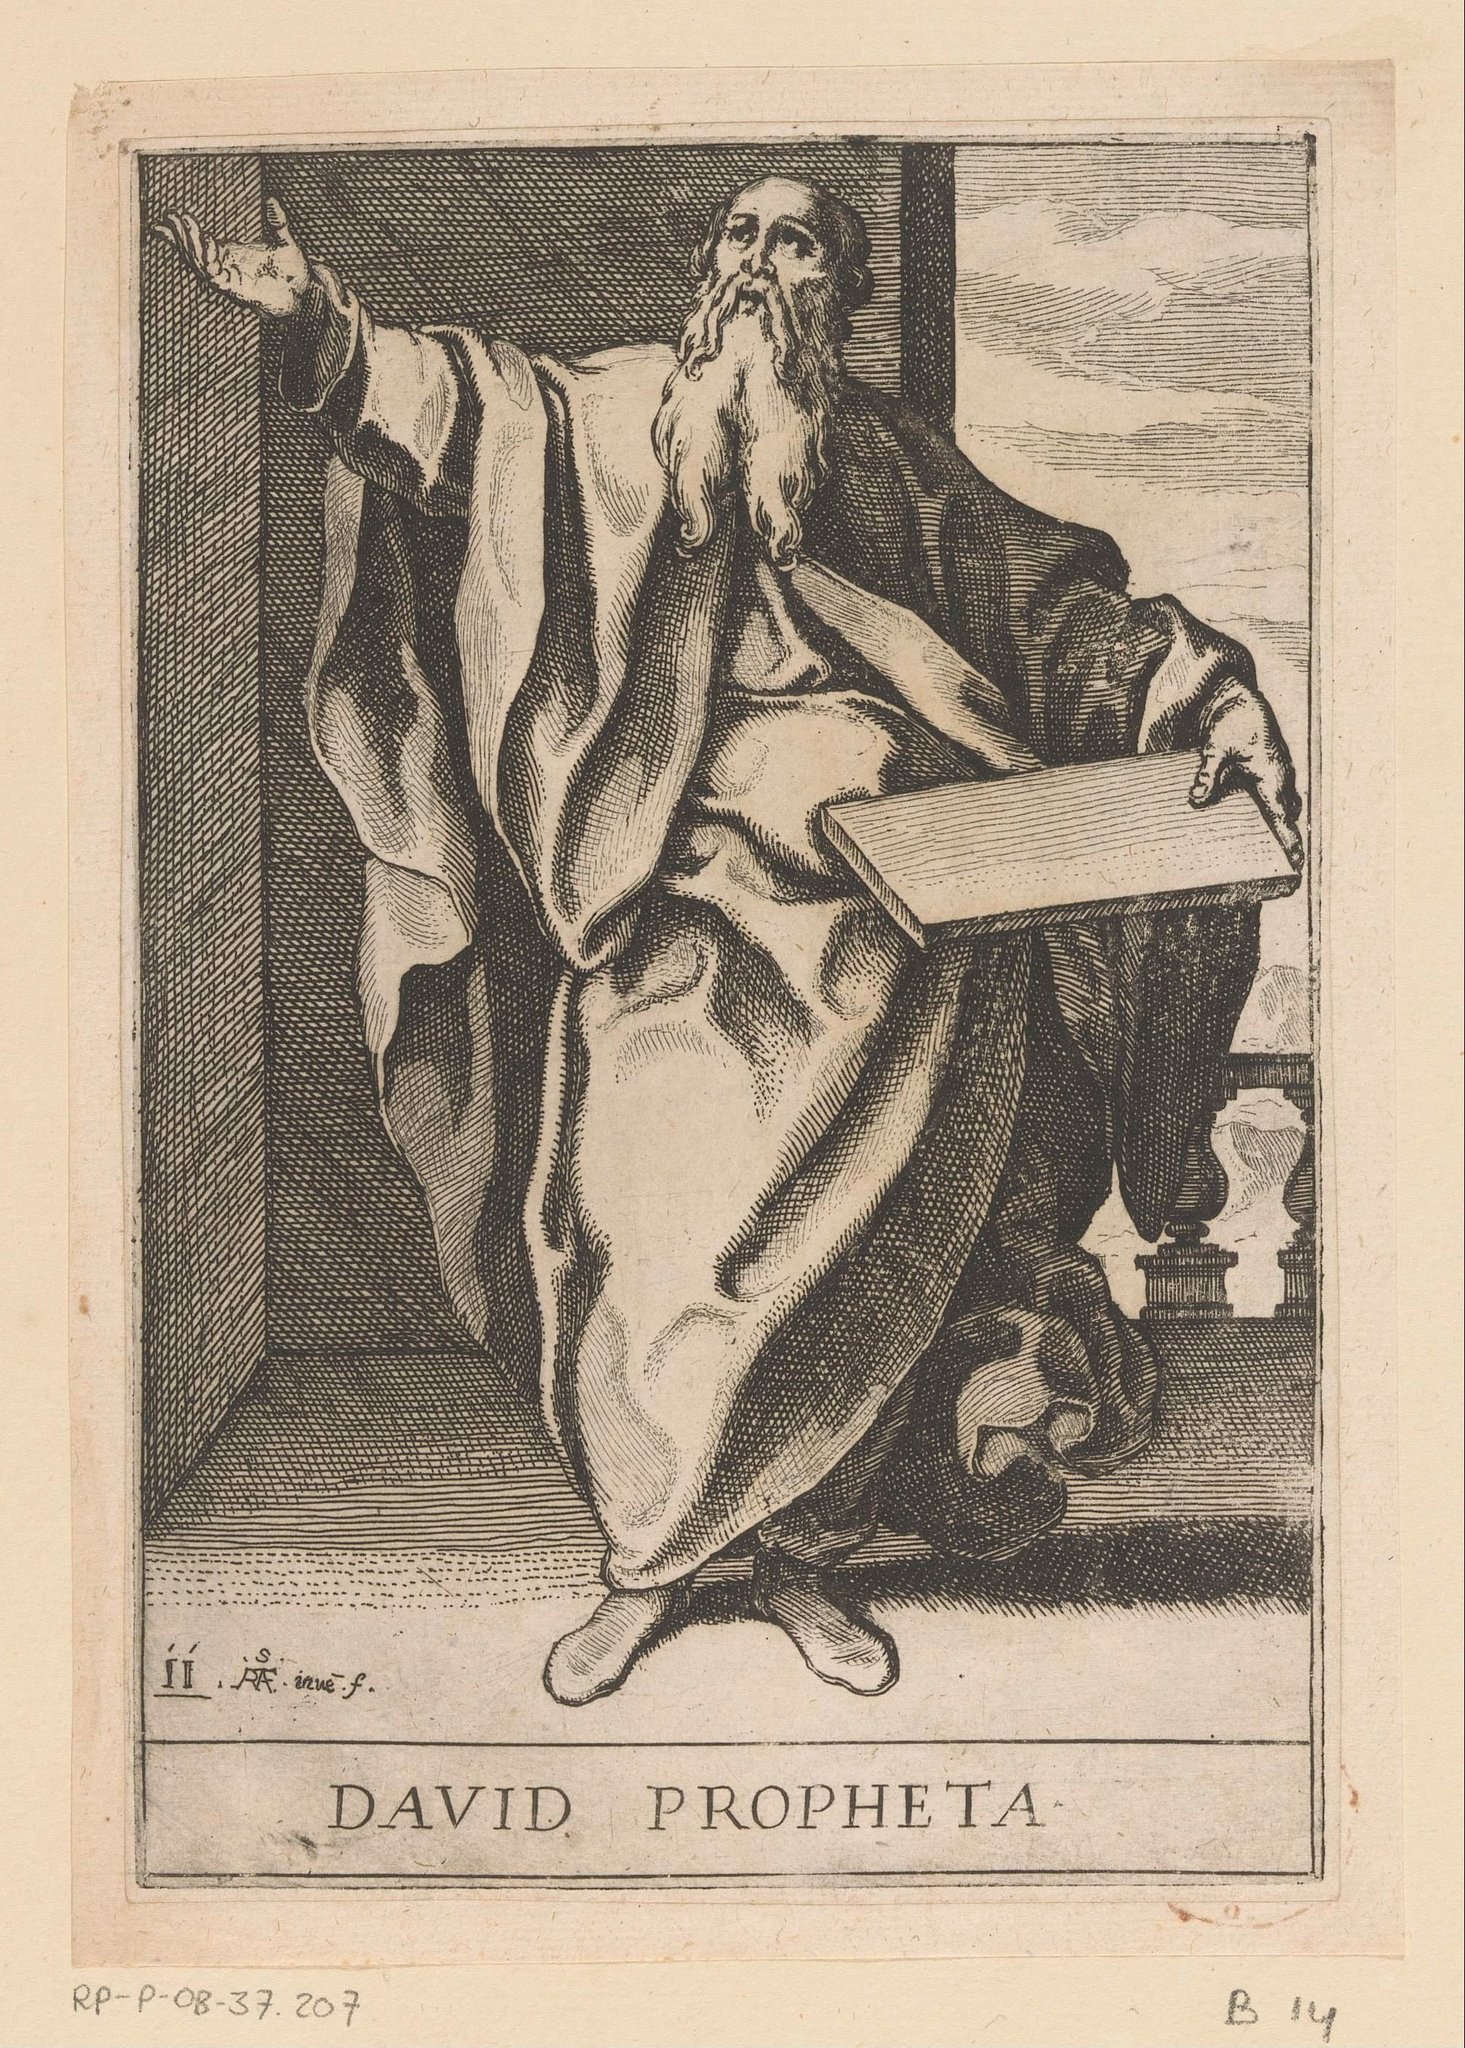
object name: print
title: Profeten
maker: raffaello schiaminossi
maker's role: painter, print maker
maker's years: 1572-1622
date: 1606-1609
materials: paper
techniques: etching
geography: italy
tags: writing tablets, prophets, sibyls, evangelists, doctors of the church; persons ~ the bible (not in biblical context), balustrade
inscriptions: collector's mark: Lugt 240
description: Deze prent maakt deel uit van een serie, bestaande uit een titelprent en twaalf prenten met voorstellingen van profeten. Van de titelpagina zijn verschillende staten bekend, onder meer een staat vóór de letter met het jaartal 1606, en een staat na de letter met het jaartal 1609. Om deze reden worden de prenten uit deze serie hier 1606-1609 gedateerd, behalve indien de individuele prent zelf gedateerd is.